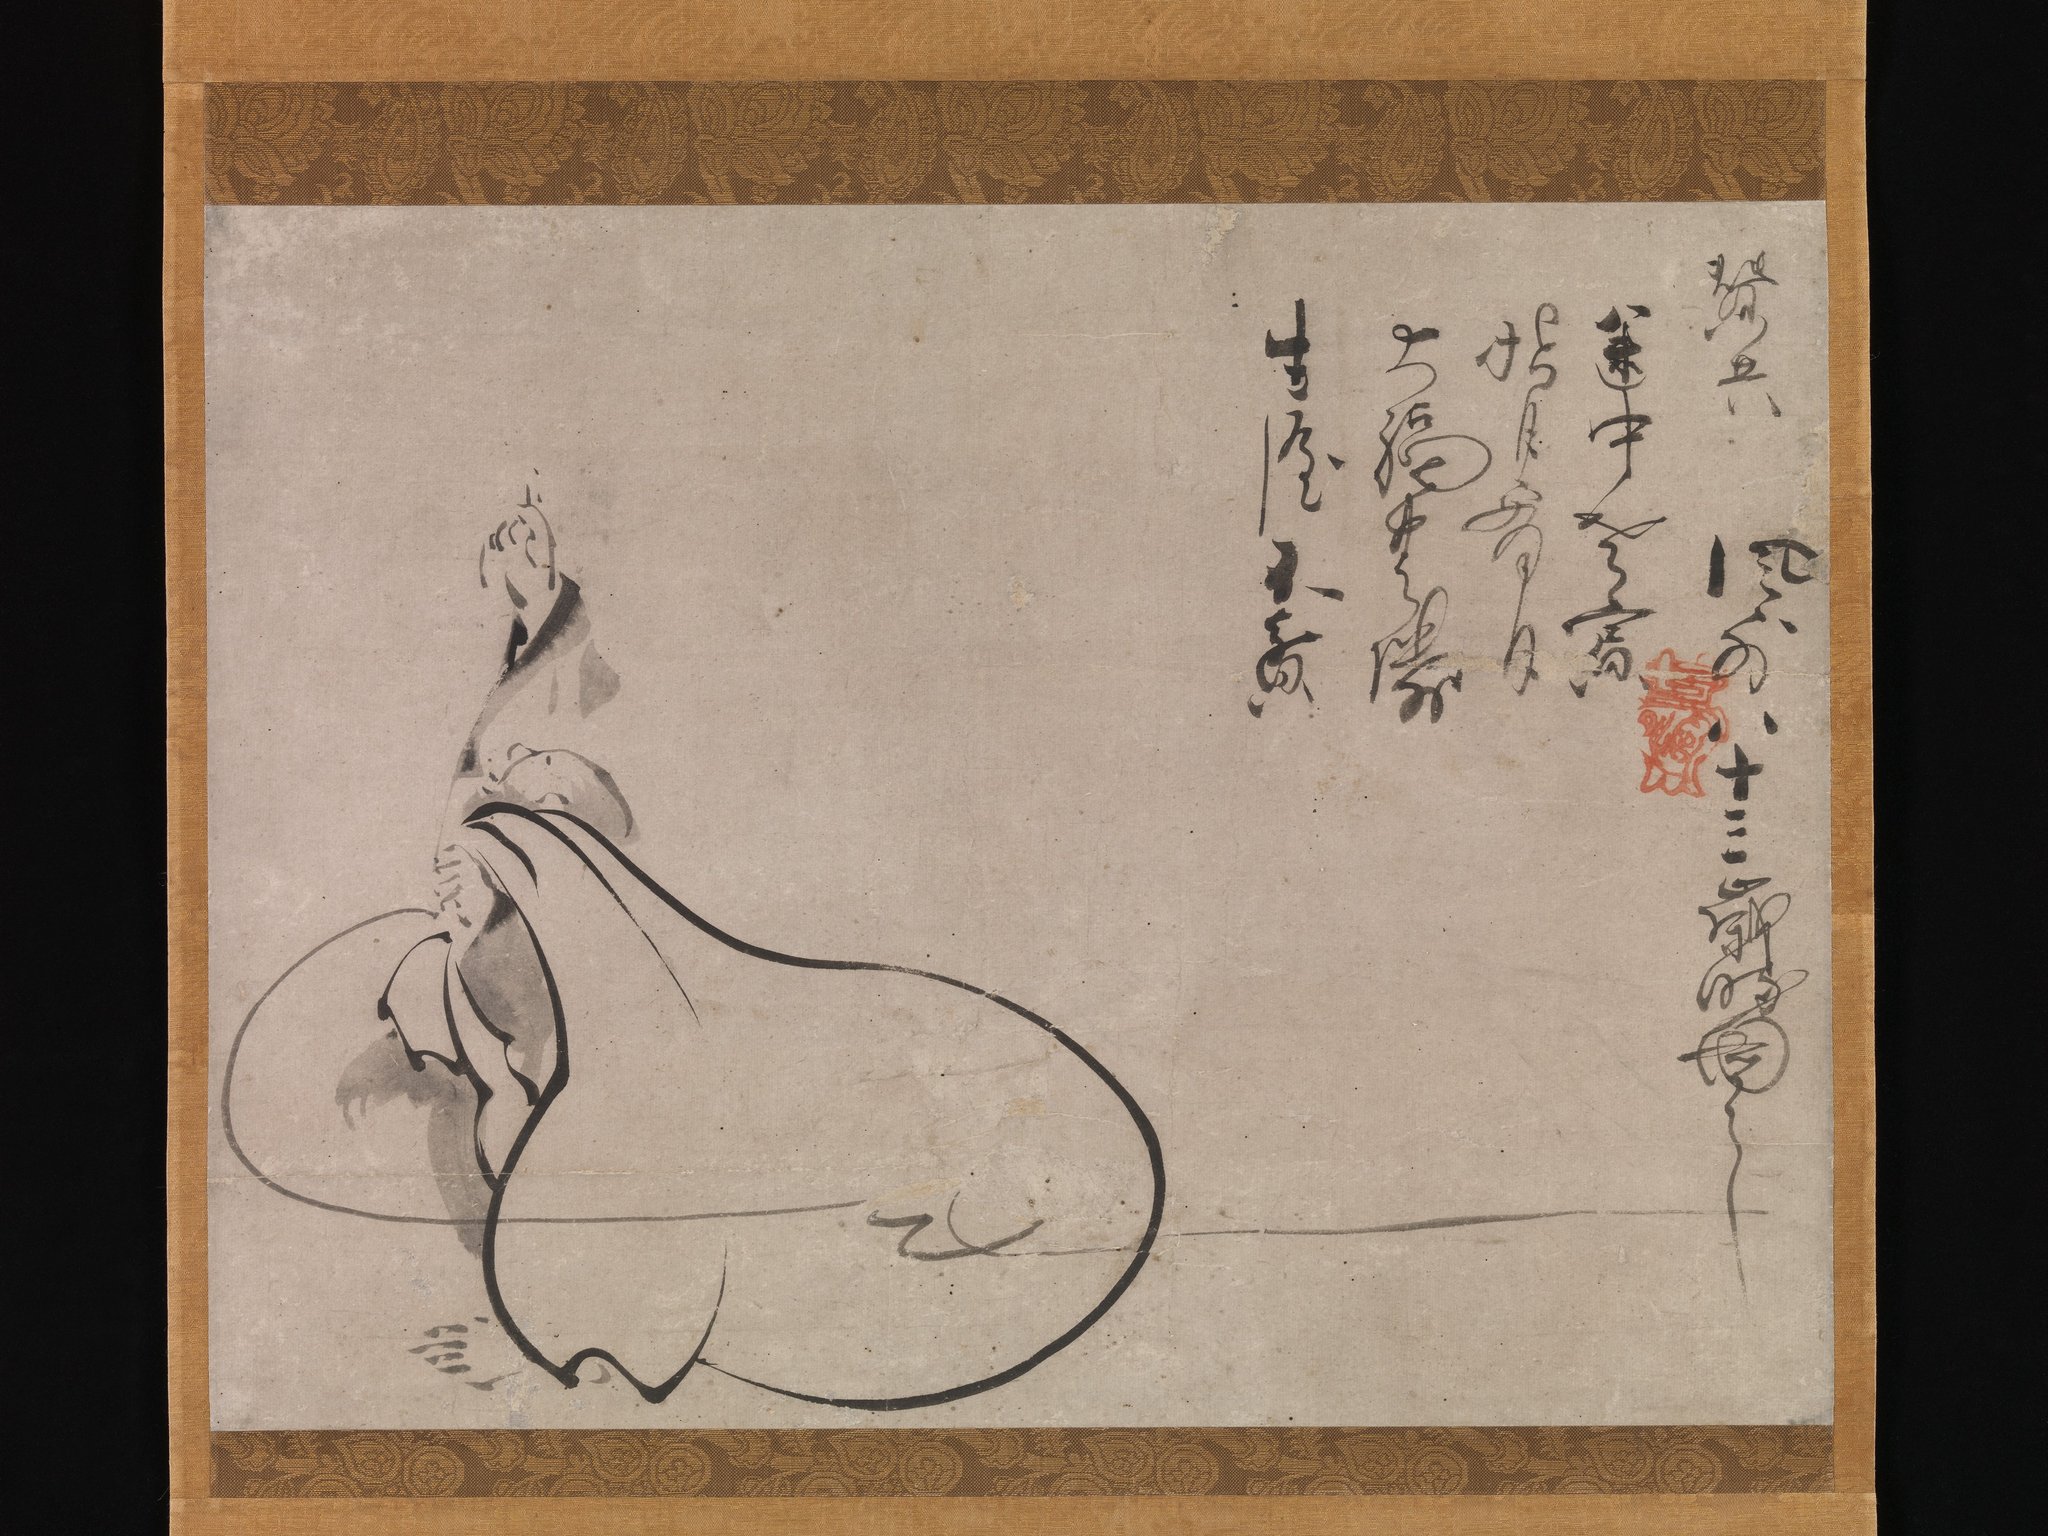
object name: hanging scroll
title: Hotei Pointing at the Moon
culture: japanese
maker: fūgai ekun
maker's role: artist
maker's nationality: japanese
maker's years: 1568-1654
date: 1650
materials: ink, paper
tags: men,monks